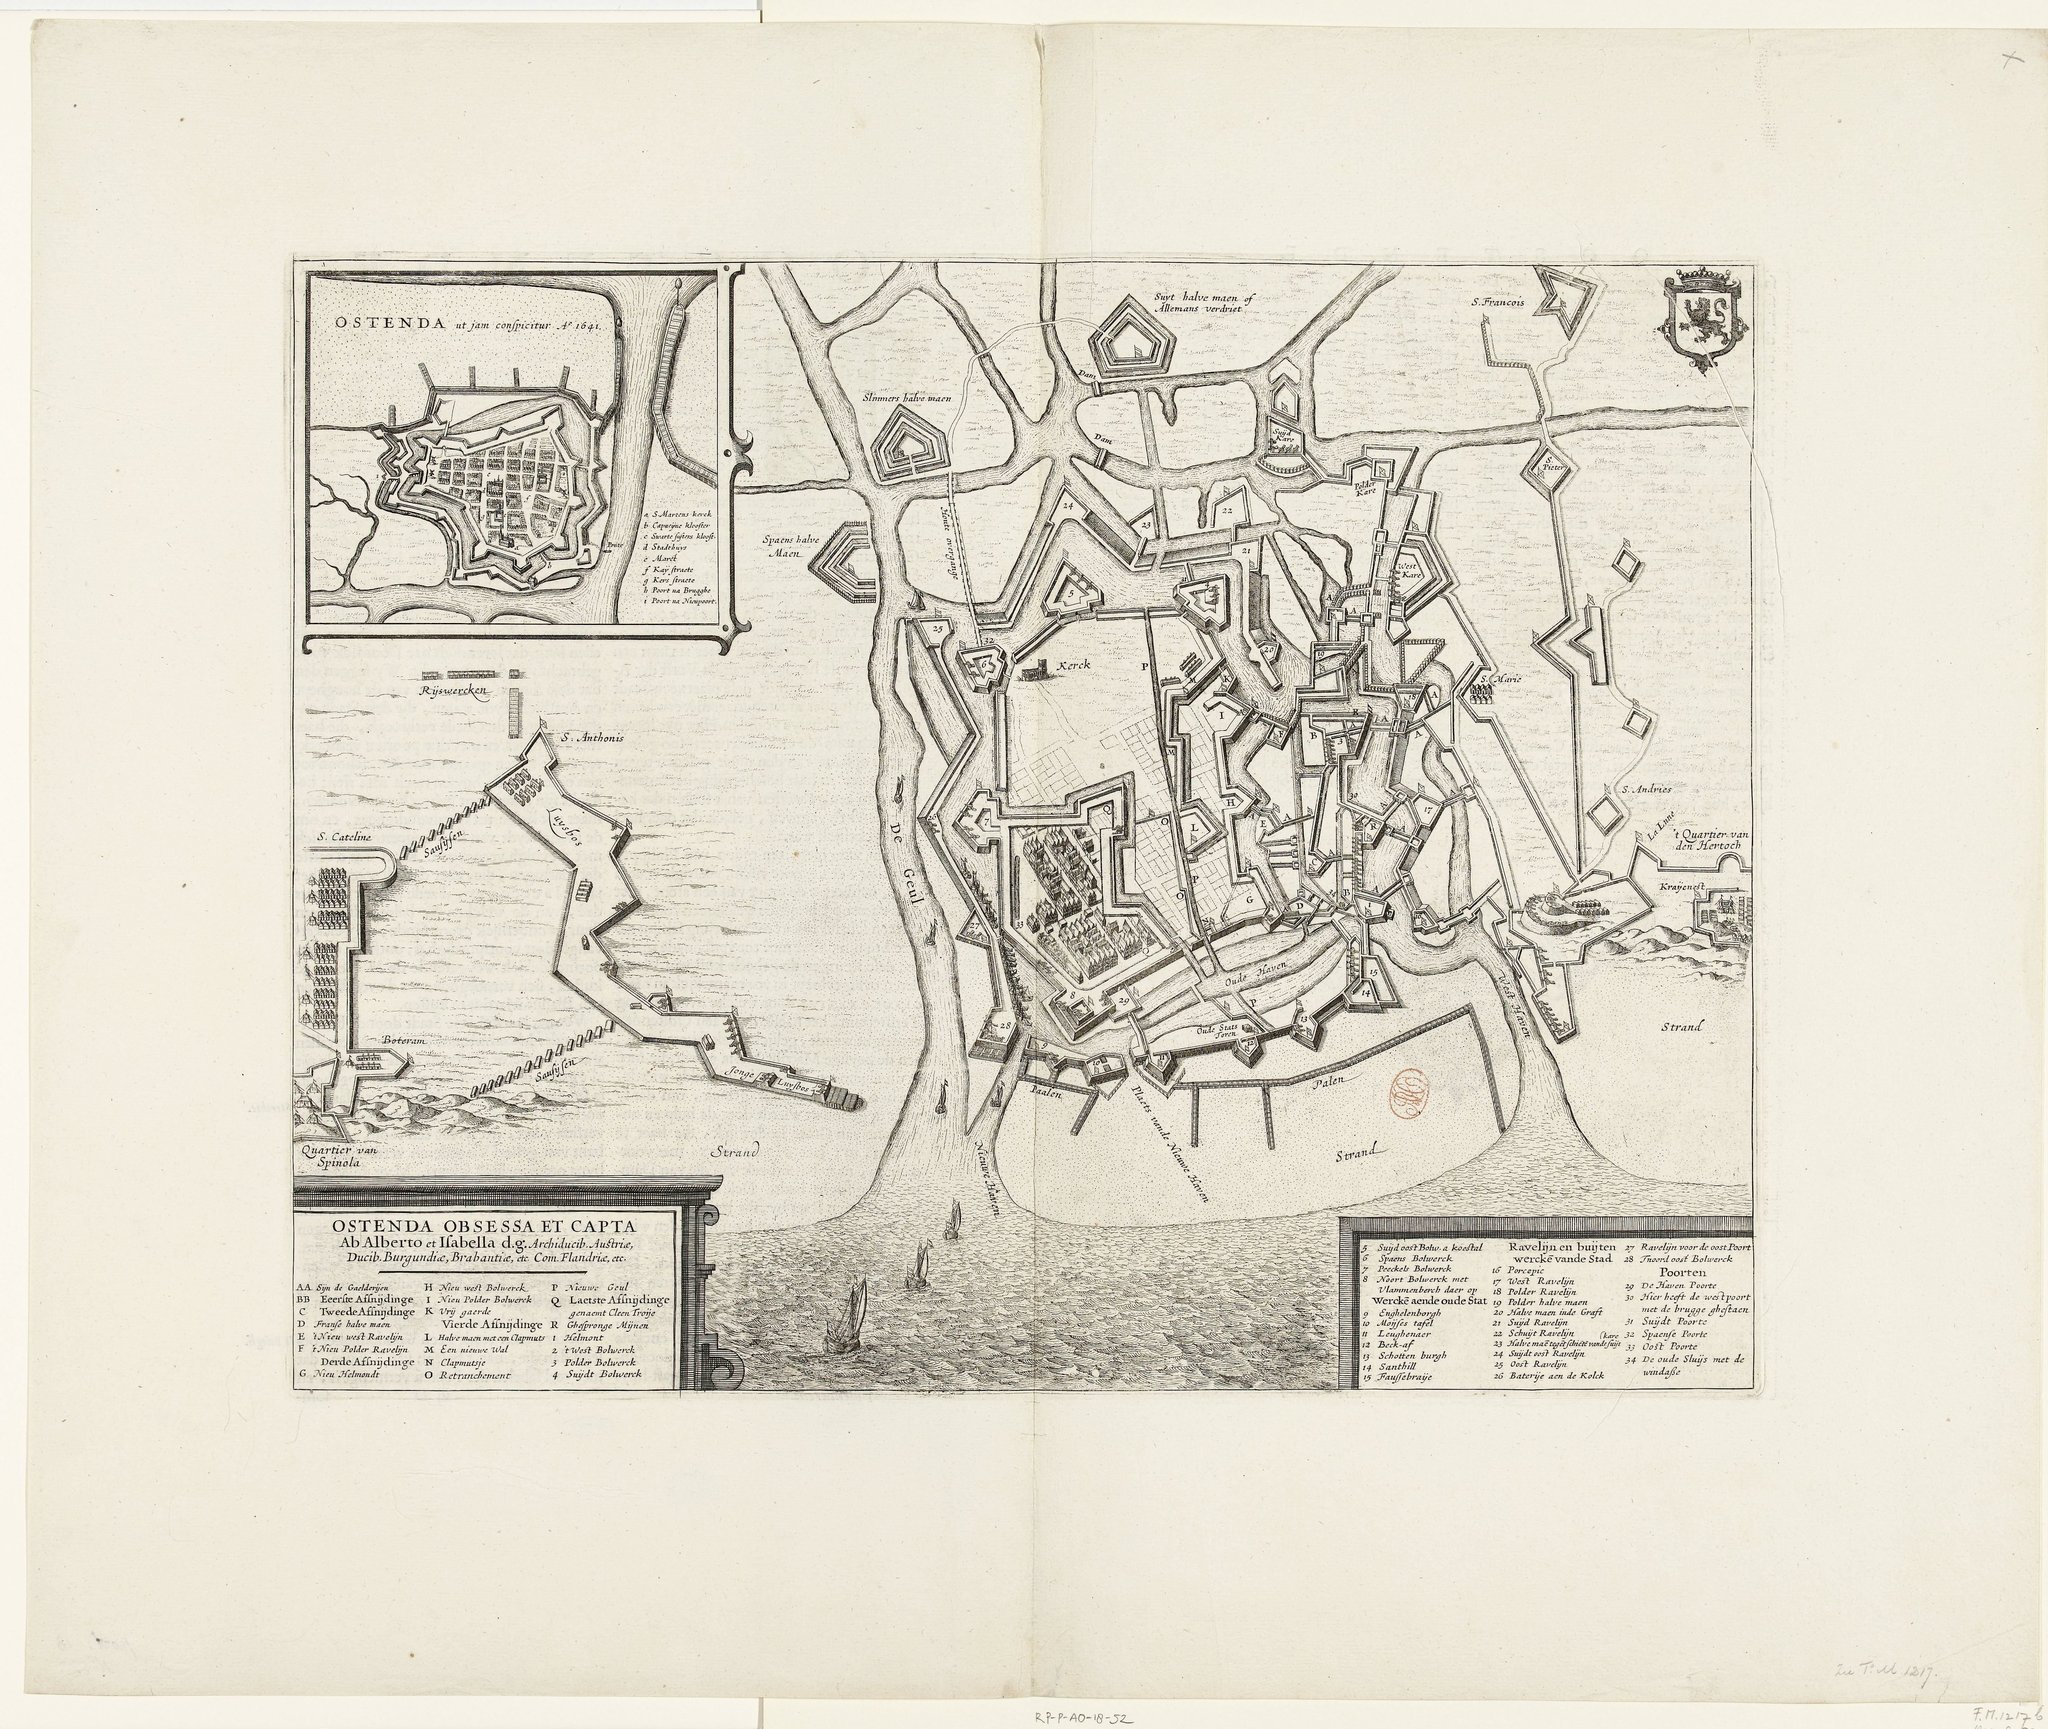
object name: history print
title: Beleg van Oostende, 1601-1604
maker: Anonymous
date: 1647-1649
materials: paper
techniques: etching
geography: northern netherlands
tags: siege, position war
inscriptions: collector's mark: Lugt 195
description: Beleg van Oostende. Kaart van de verdedigings- en aanvalslinies rondom de stad en in het omliggende gebied, links het kwartier van Spinola, rechts het kwartier van aartshertog Albrecht. Onderaan twee cartouches met de titel en de legenda's A-R en 1-34. Linksboven een inzet met een plattegrond van de stad in 1641. Op een dubbelblad genomen uit het Stedenboek van Blaeu, bedrukt op achterzijde met tekst in het Nederlands.